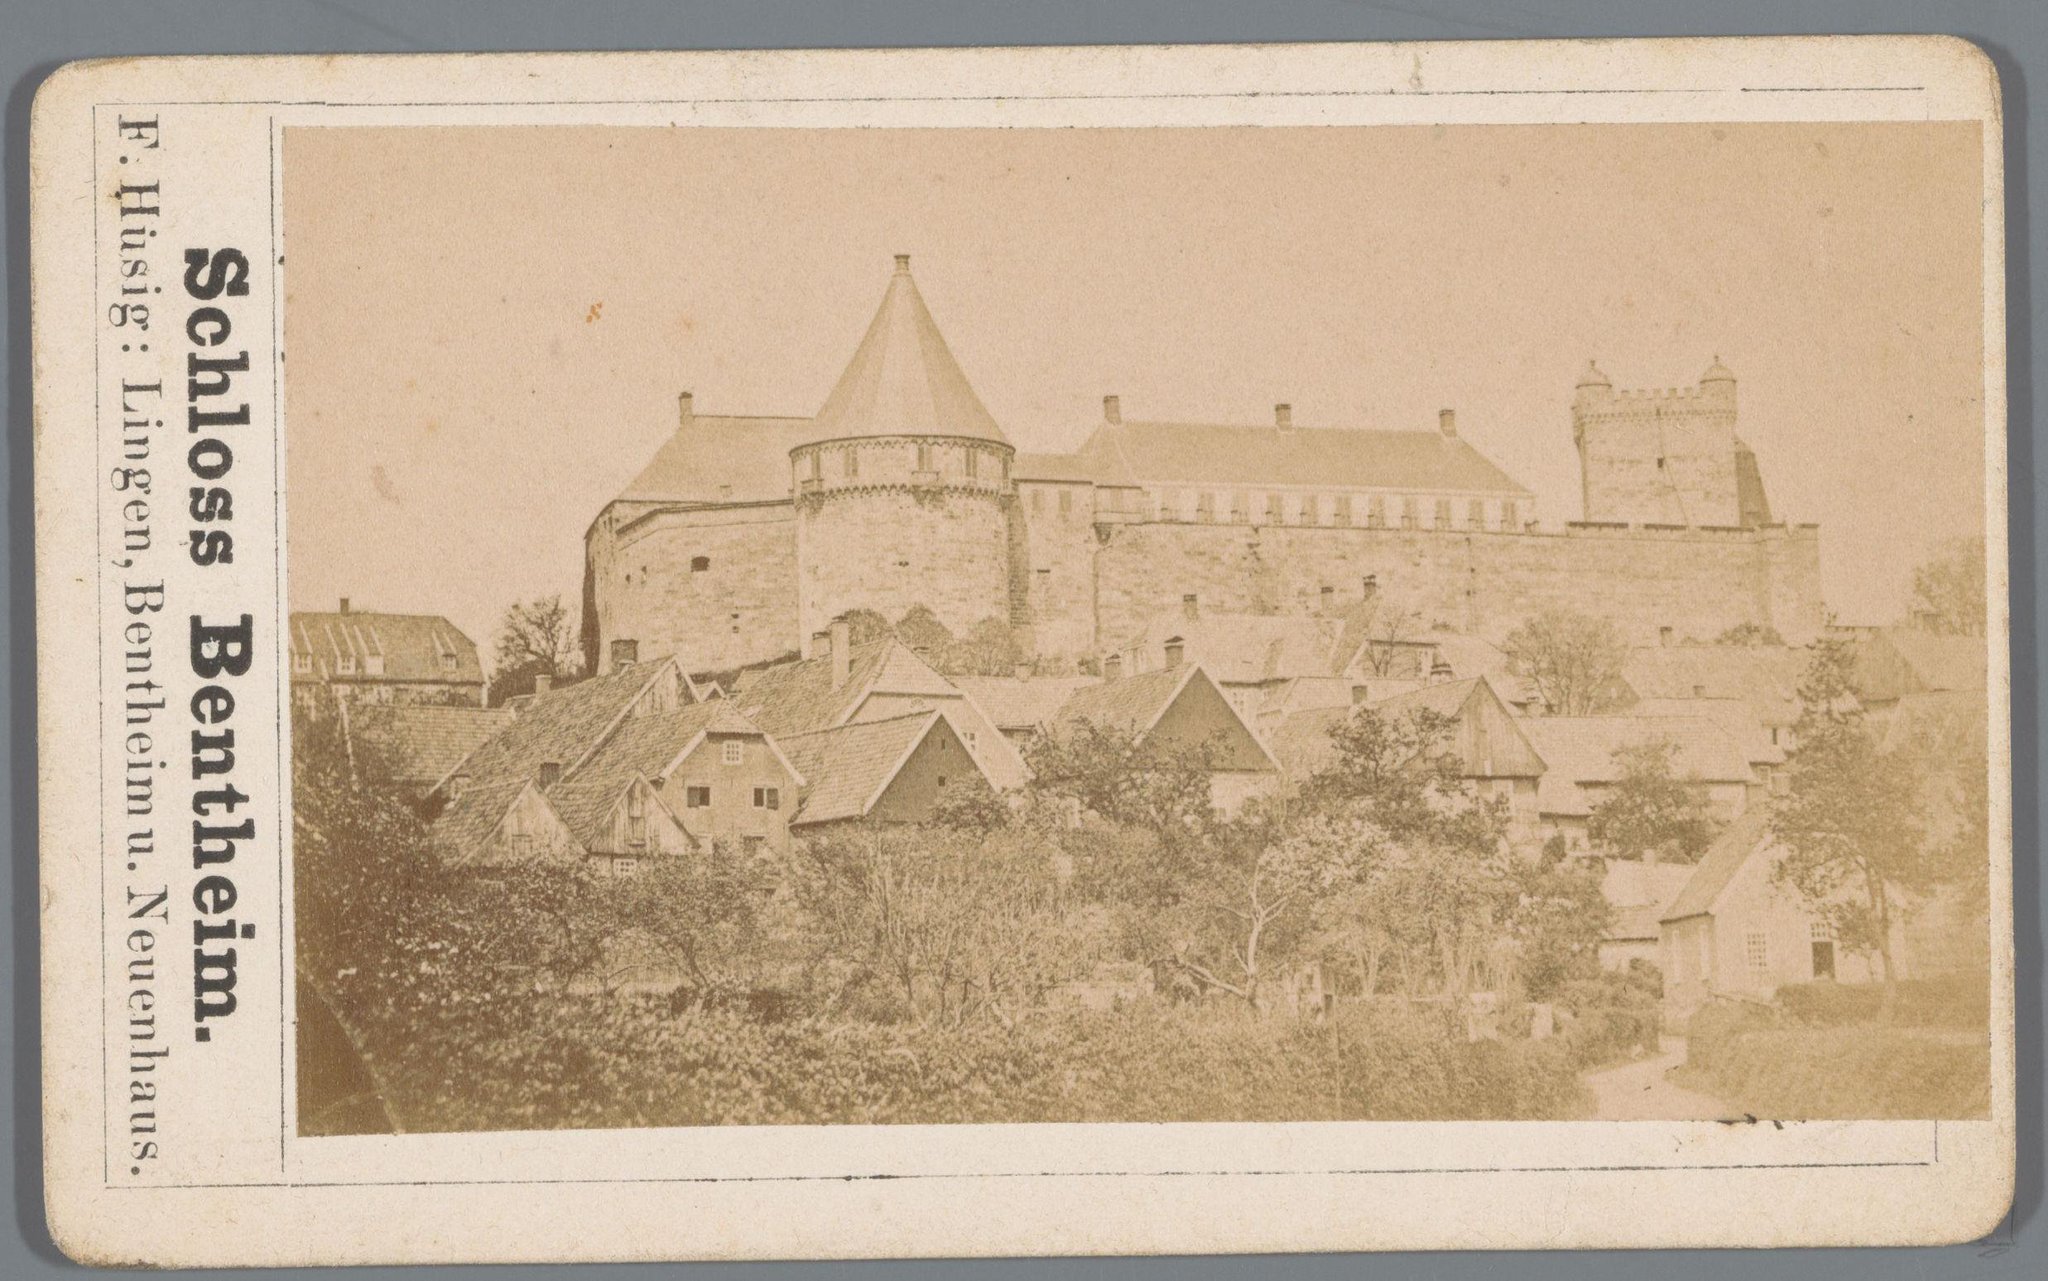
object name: carte de visite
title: Schloss Bentheim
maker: fritz hüsig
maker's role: fotograaf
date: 1870-1885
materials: cardboard, paper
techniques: albumen print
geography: bad bentheim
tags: castle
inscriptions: inscription: ‘Photogr. Atelier/ von/ Fritz Hüsig/ LINGEN./ NIEPCE. DAGUERRE. TALBOT./ Die Platte/ bleibt für Nachbestellungen aufbewahrt.’